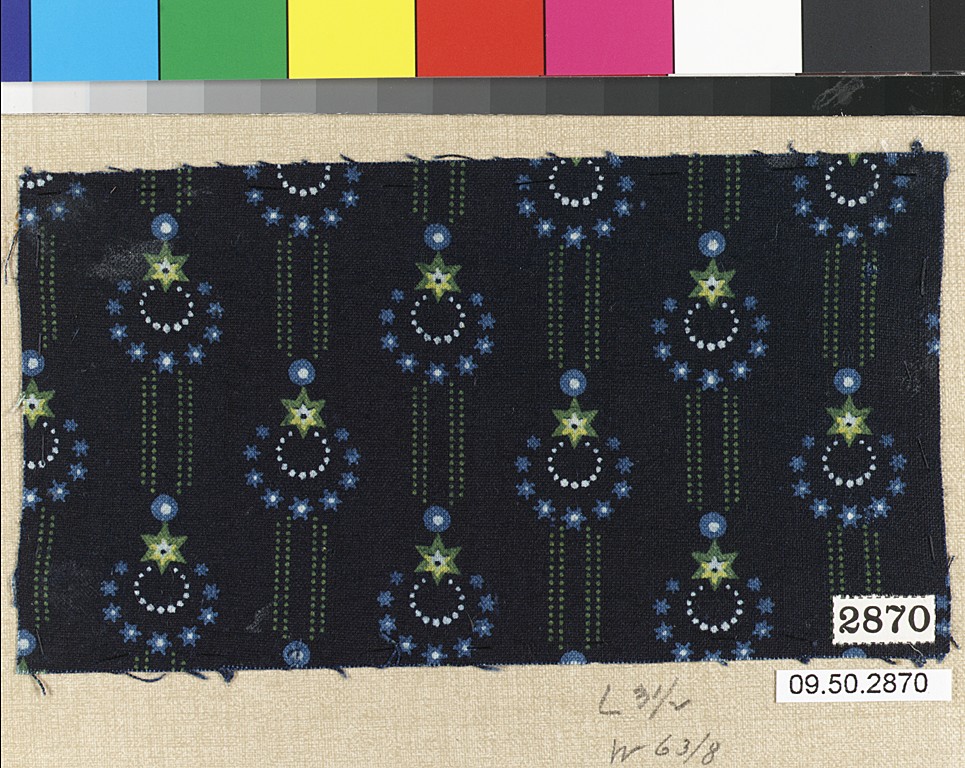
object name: piece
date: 1801-1900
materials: cotton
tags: stars